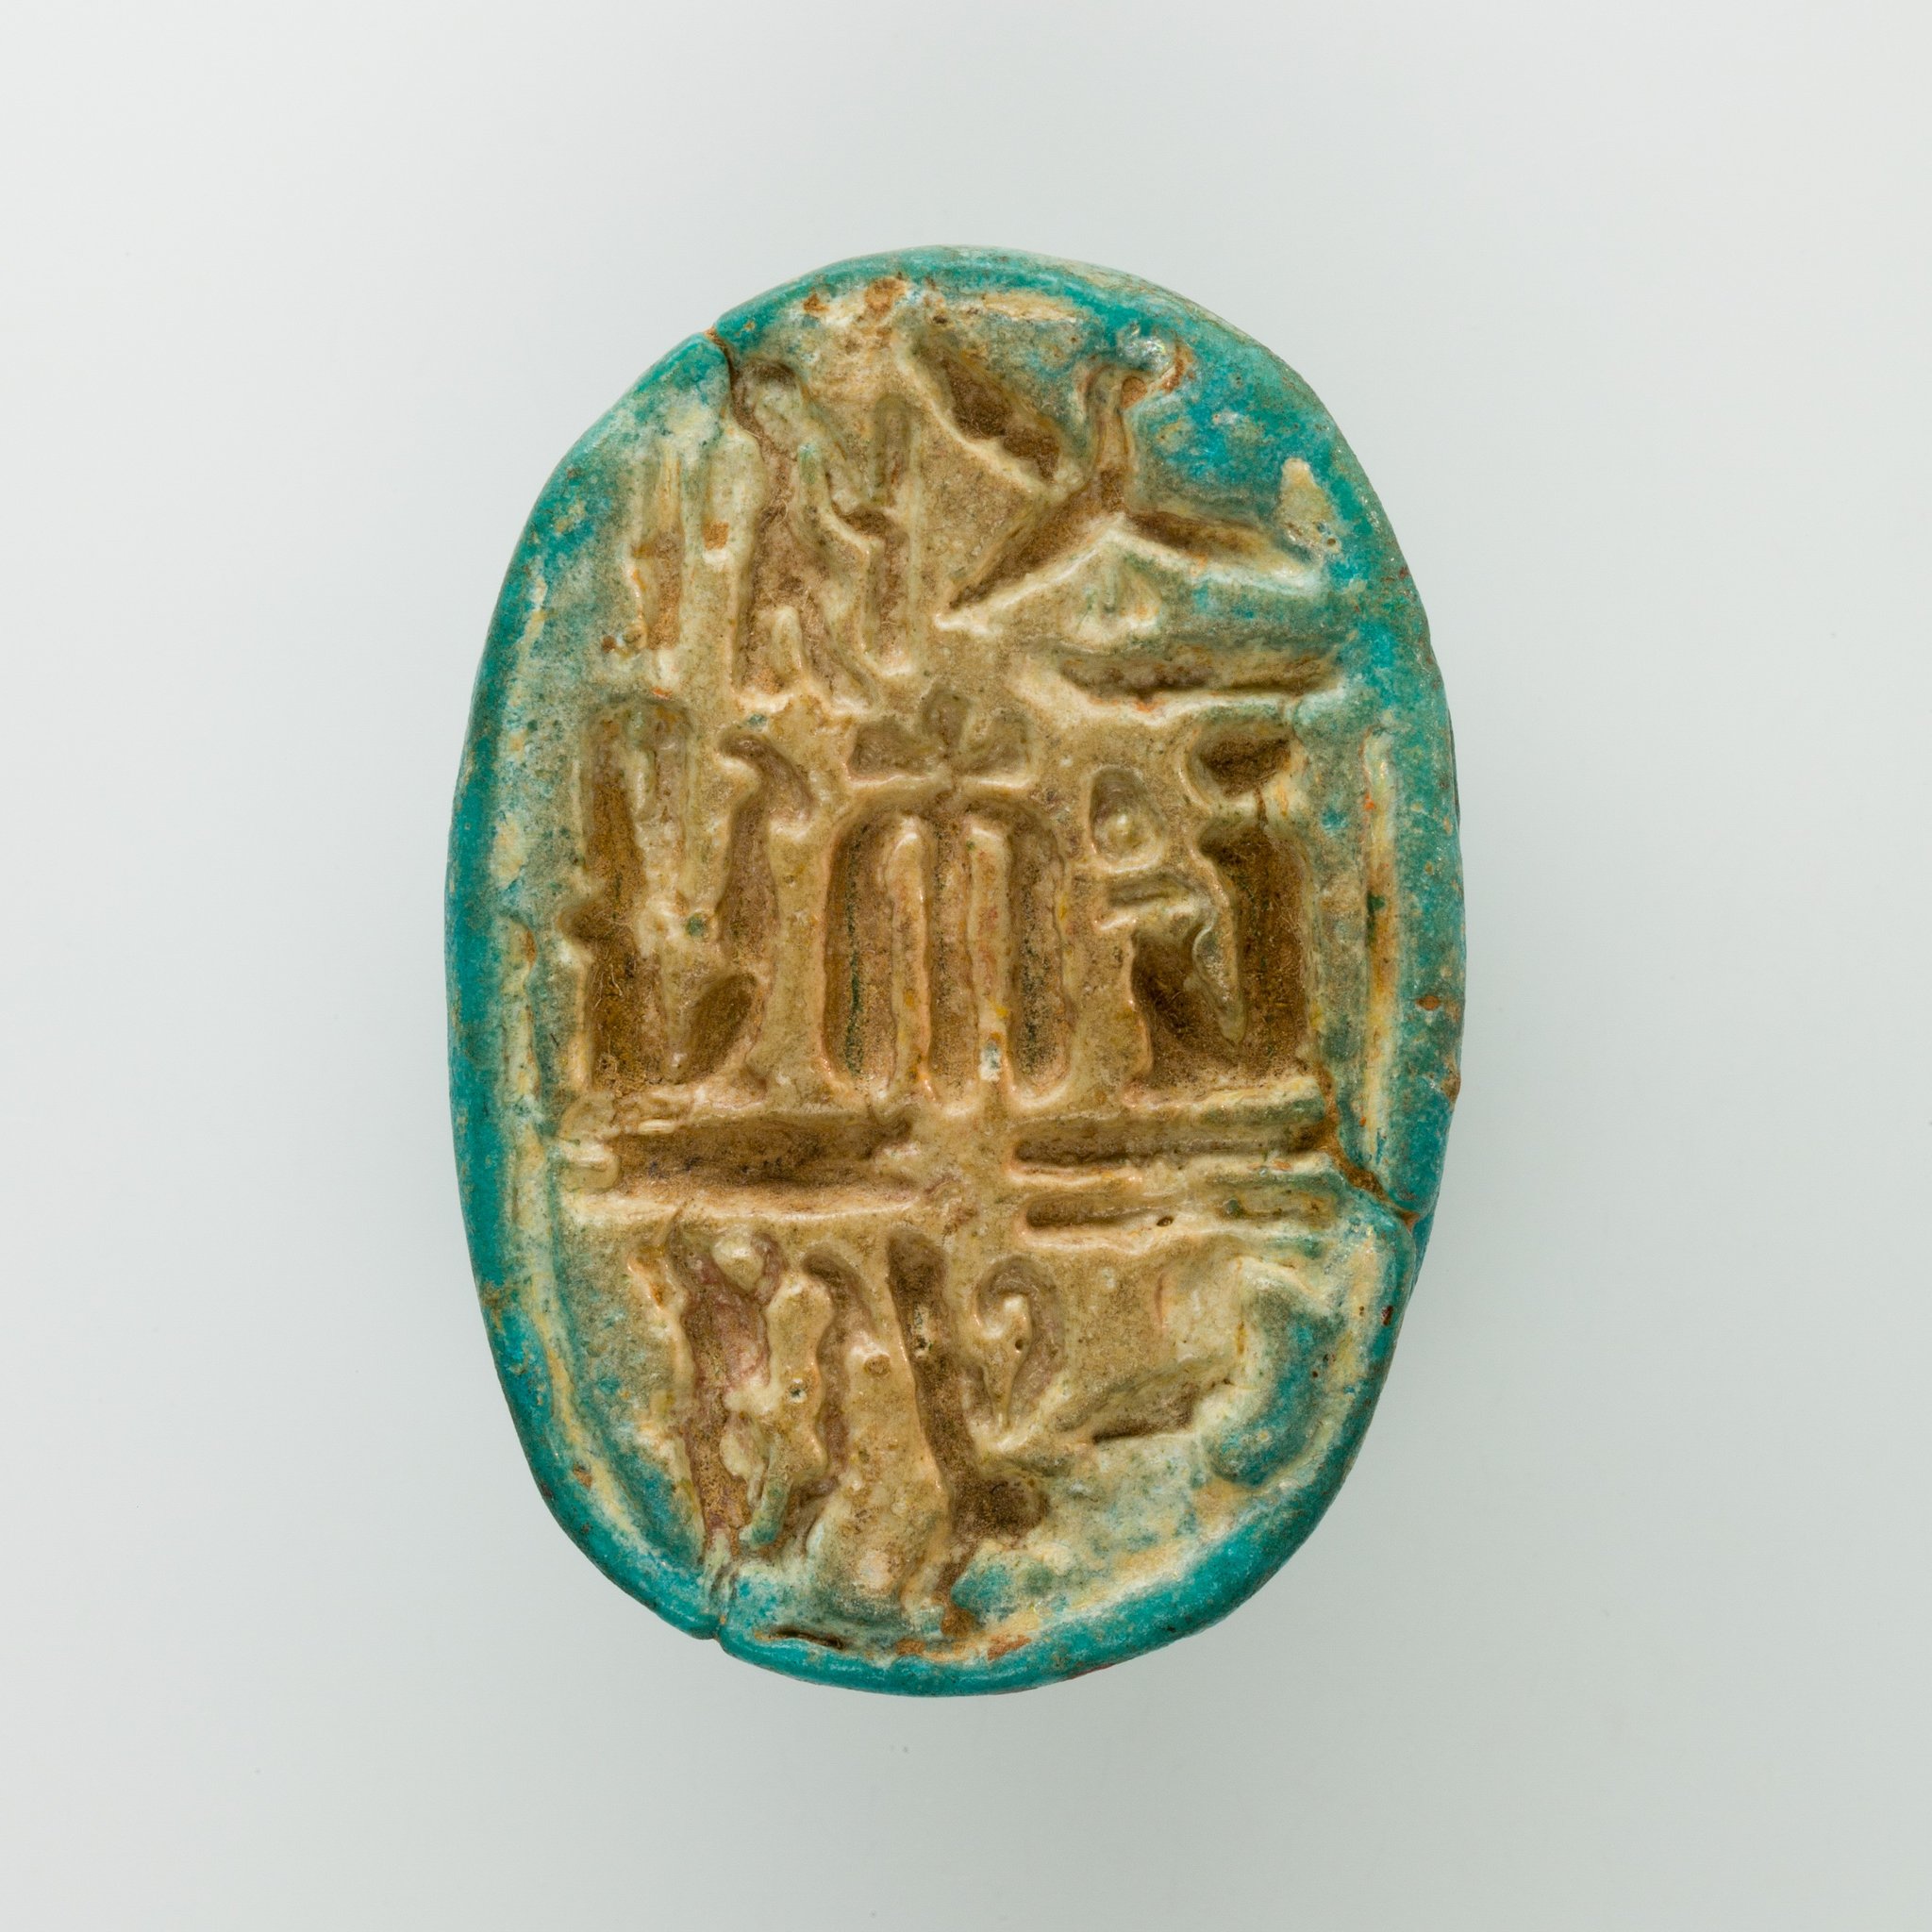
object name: scarab, ramesses ii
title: Scarab of Ramesses VII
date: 1550-1070 BCE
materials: faience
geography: egypt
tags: hieroglyphs,scarabs